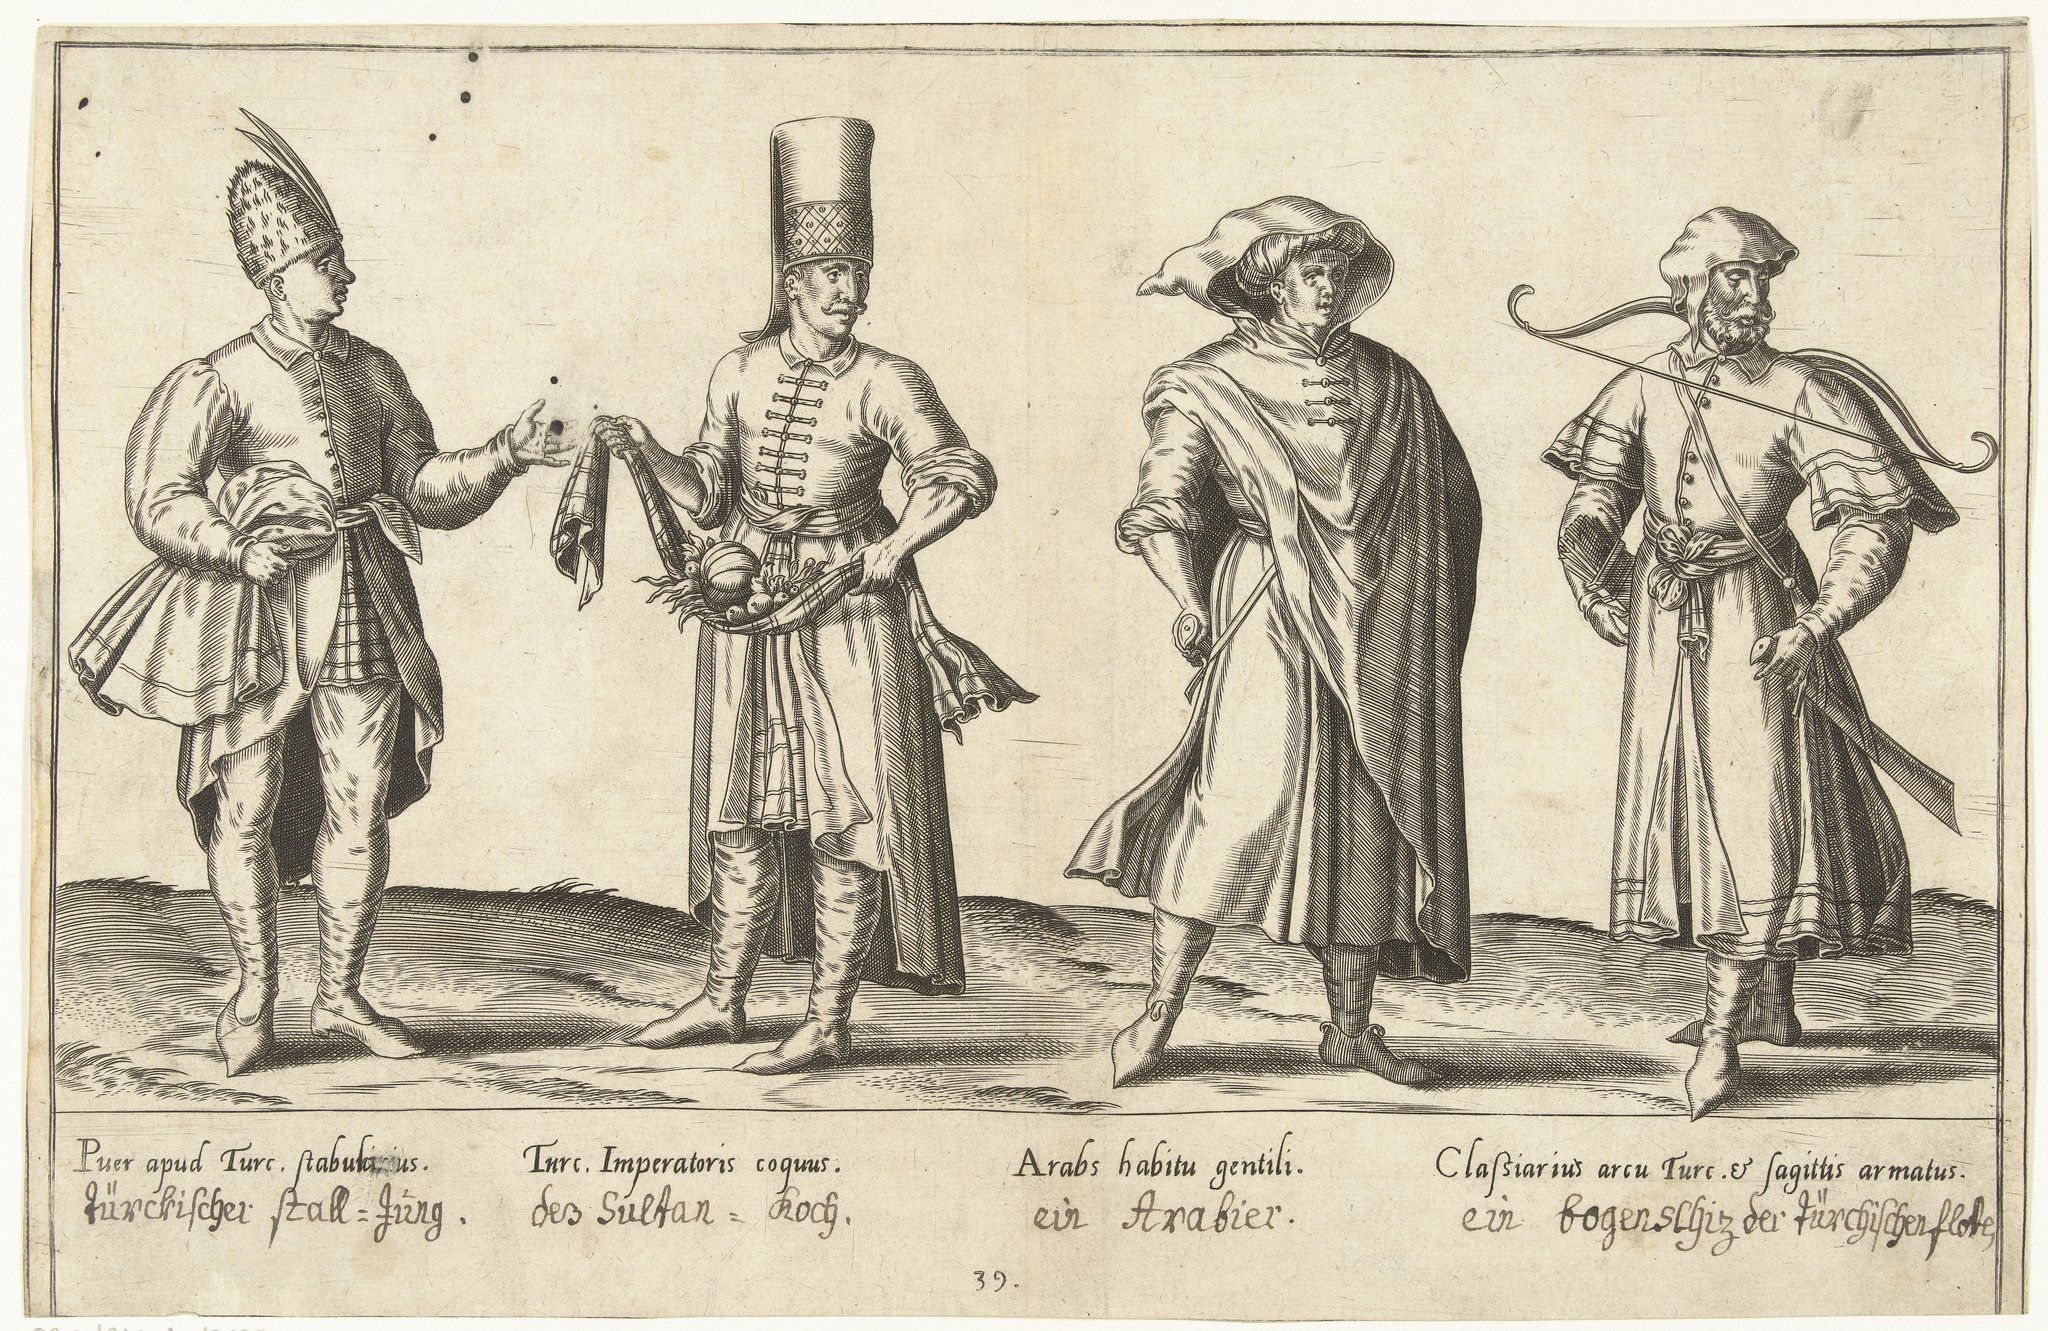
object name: costume print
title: Kleding van Ottomanen en Arabieren rond 1580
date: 1581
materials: paper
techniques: engraving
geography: antwerp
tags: asiatic races and peoples: turks, cook, clothes, costume (+ men's clothes), warfare; military affairs (+ infantry), stall, stable (+ men (labourers)), asiatic races and peoples (with name)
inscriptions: caption: ‘Türckischer Stall-jung, des Sultan= Koch. Ein Arabier. ein bogenschuz der Türkischen Flote’, collector's mark: Lugt 2228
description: Prent uit een boek over zestiende-eeuwse kleding rond 1580. Vier mannen uit het Ottomaanse rijk. Alle vier zijn anders gekleed. Van links naar rechts: een Ottomaanse stalknecht, een Ottomaanse kok met ingrediënten in zijn handen, een Arabier en een boogschutter van de Ottomaanse vloot. De prent heeft een Latijns onderschrift.